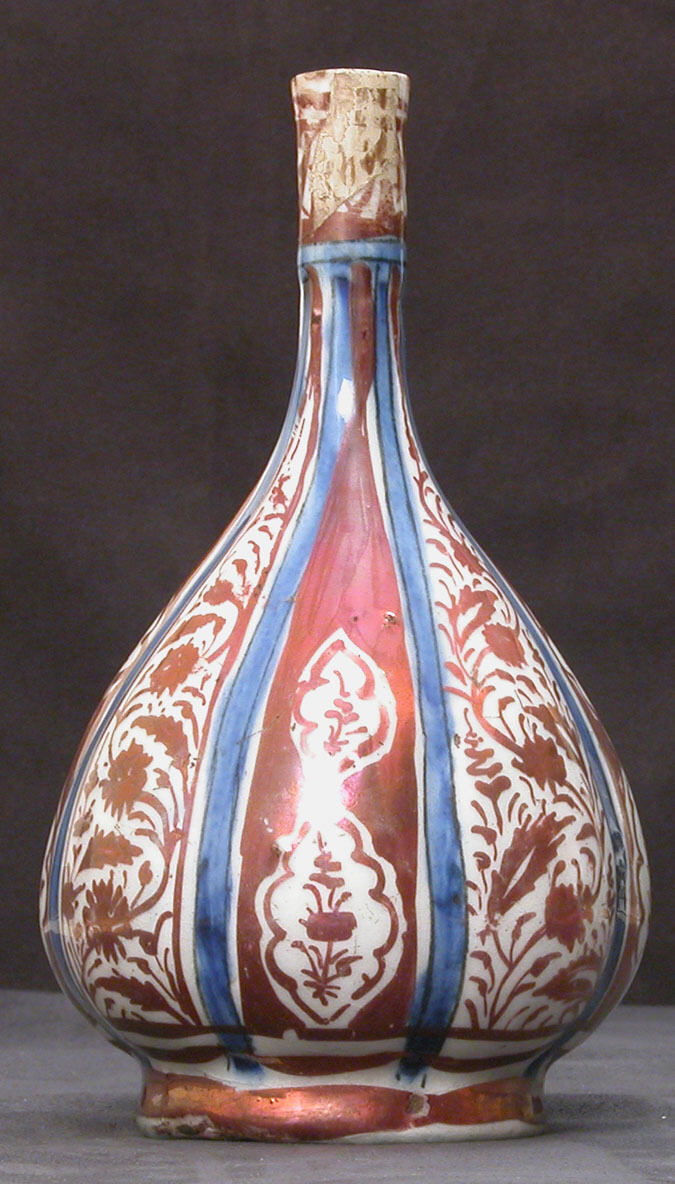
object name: bottle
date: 1601-1700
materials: glaze, stonepaste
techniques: luster painting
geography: iran